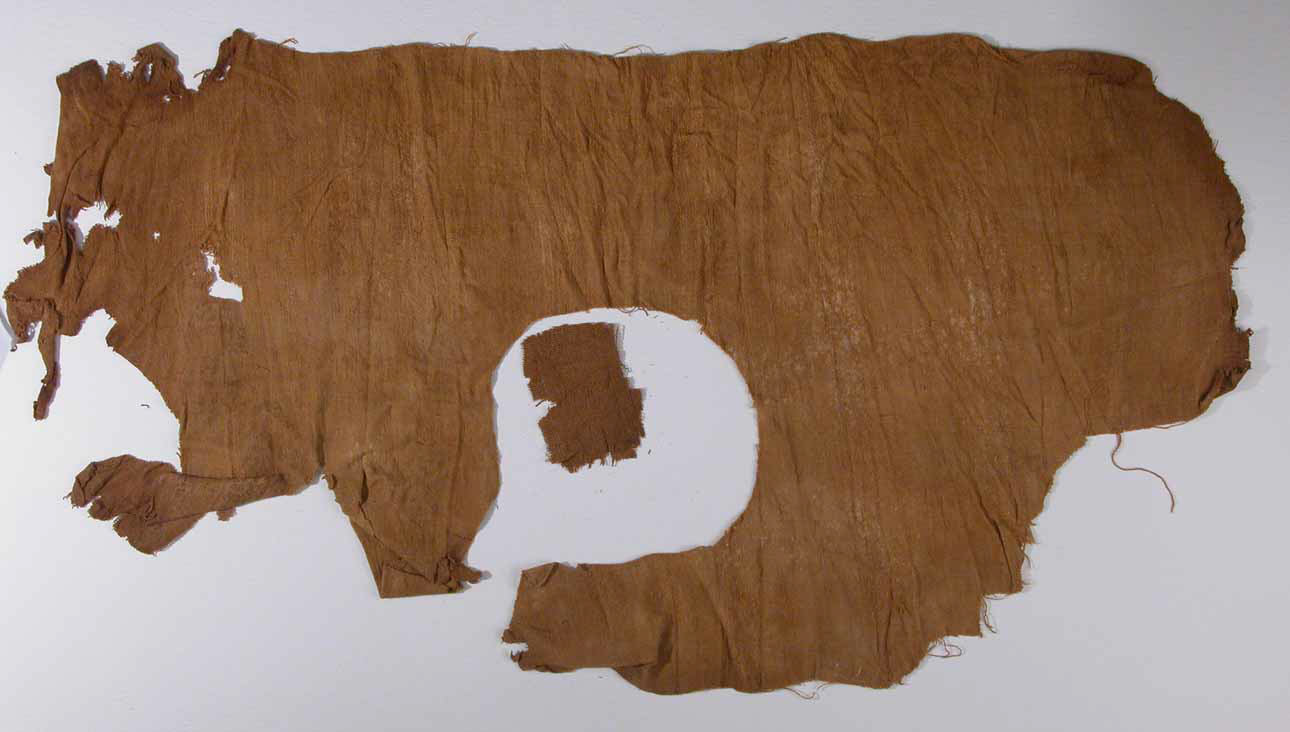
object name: fragment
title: Textile Fragment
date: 301-700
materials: linen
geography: egypt